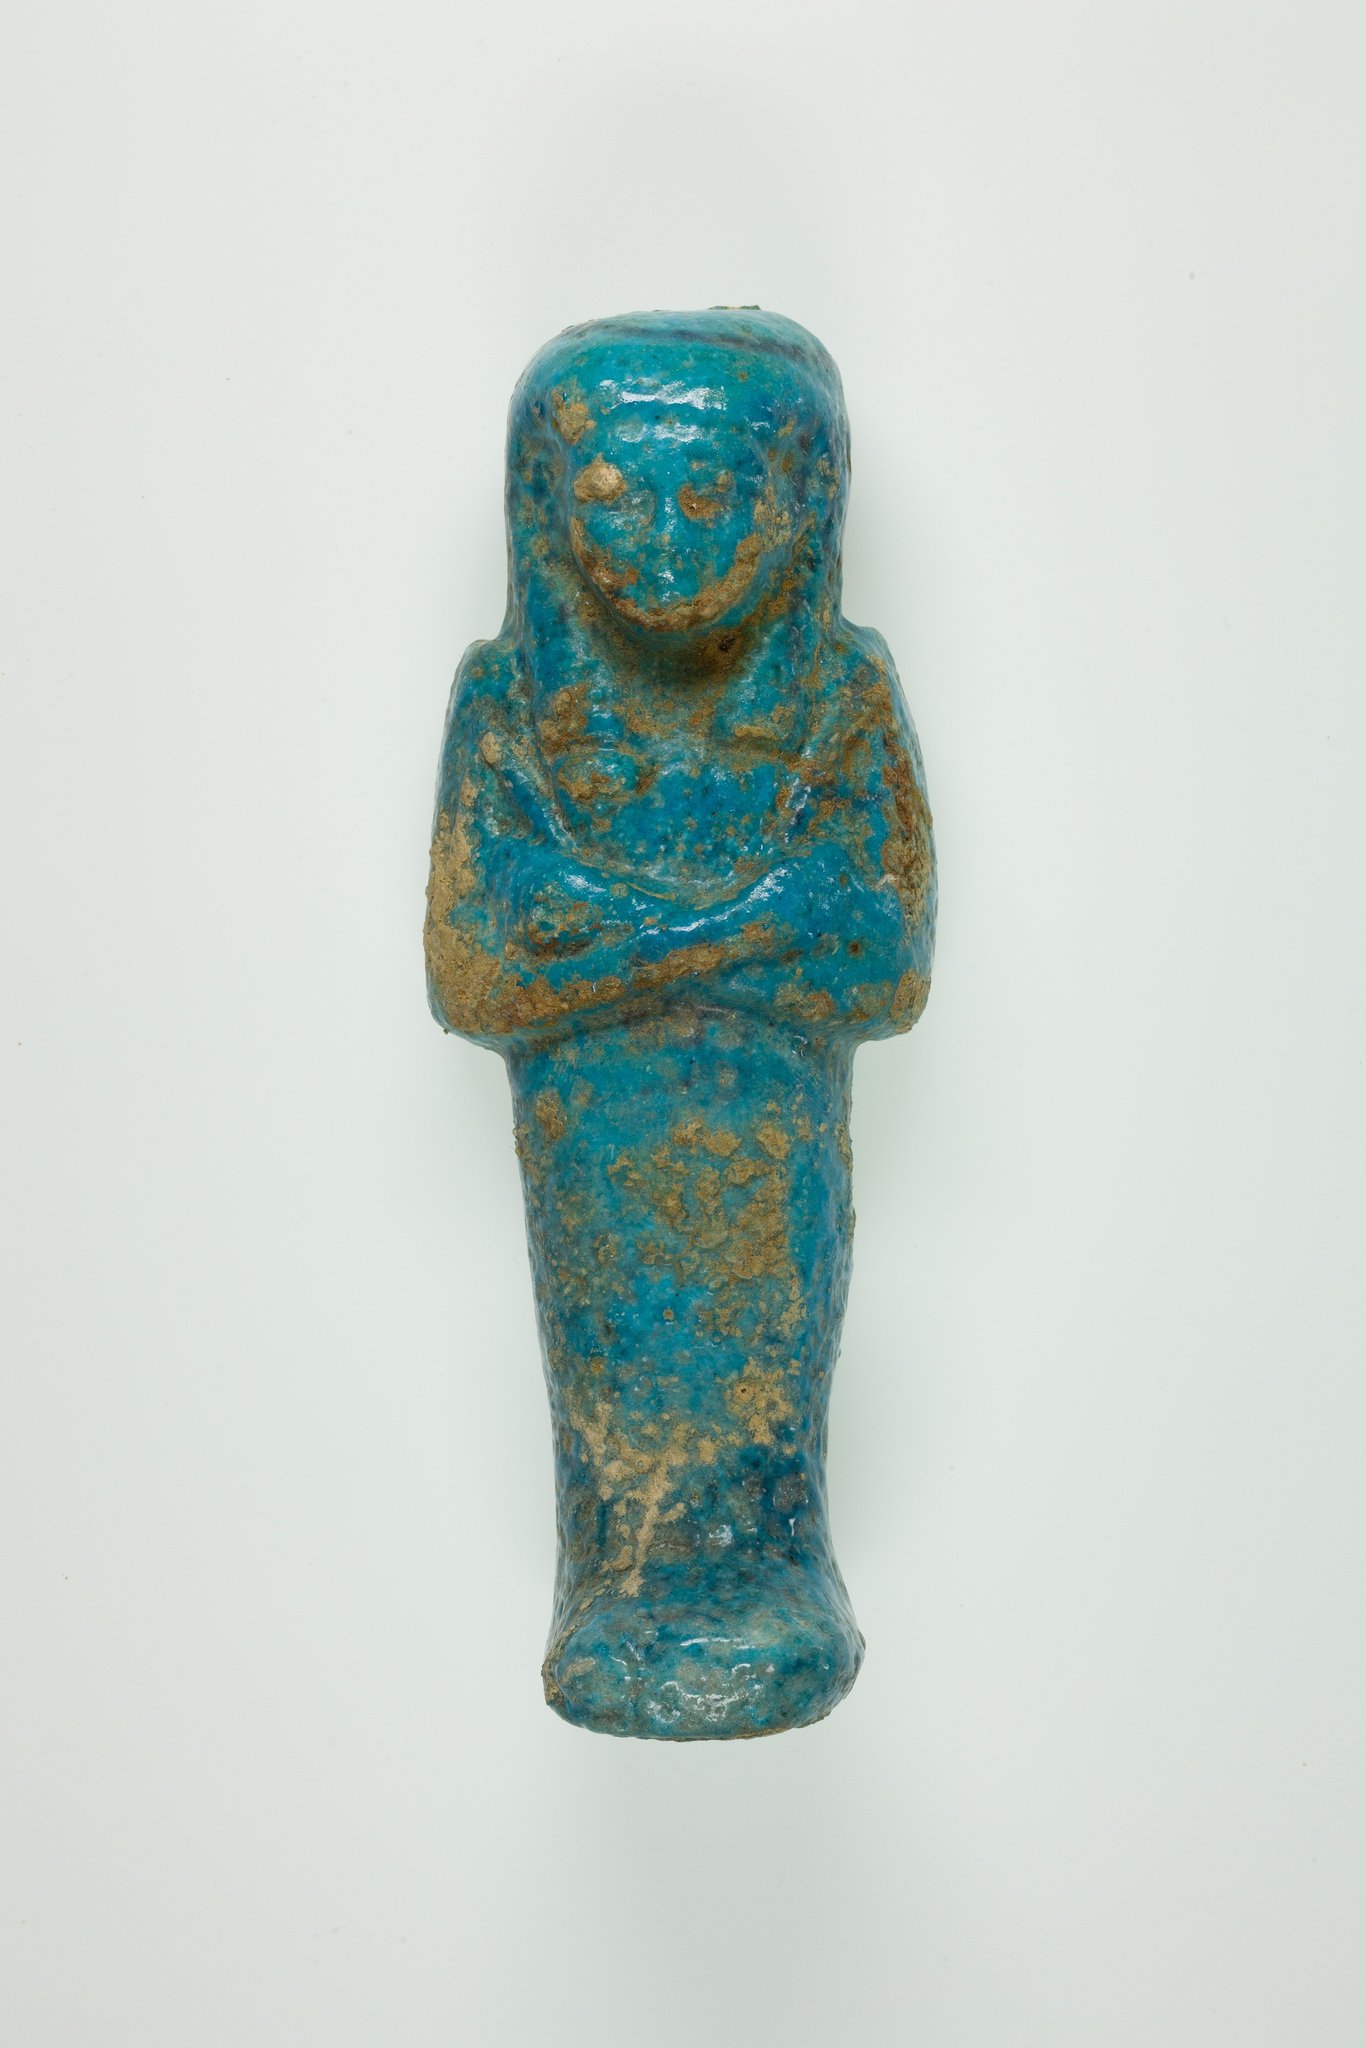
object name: worker shabti, henettawy c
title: Worker Shabti of Henettawy (C), Daughter of Isetemkheb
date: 990-970 BCE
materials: faience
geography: egypt